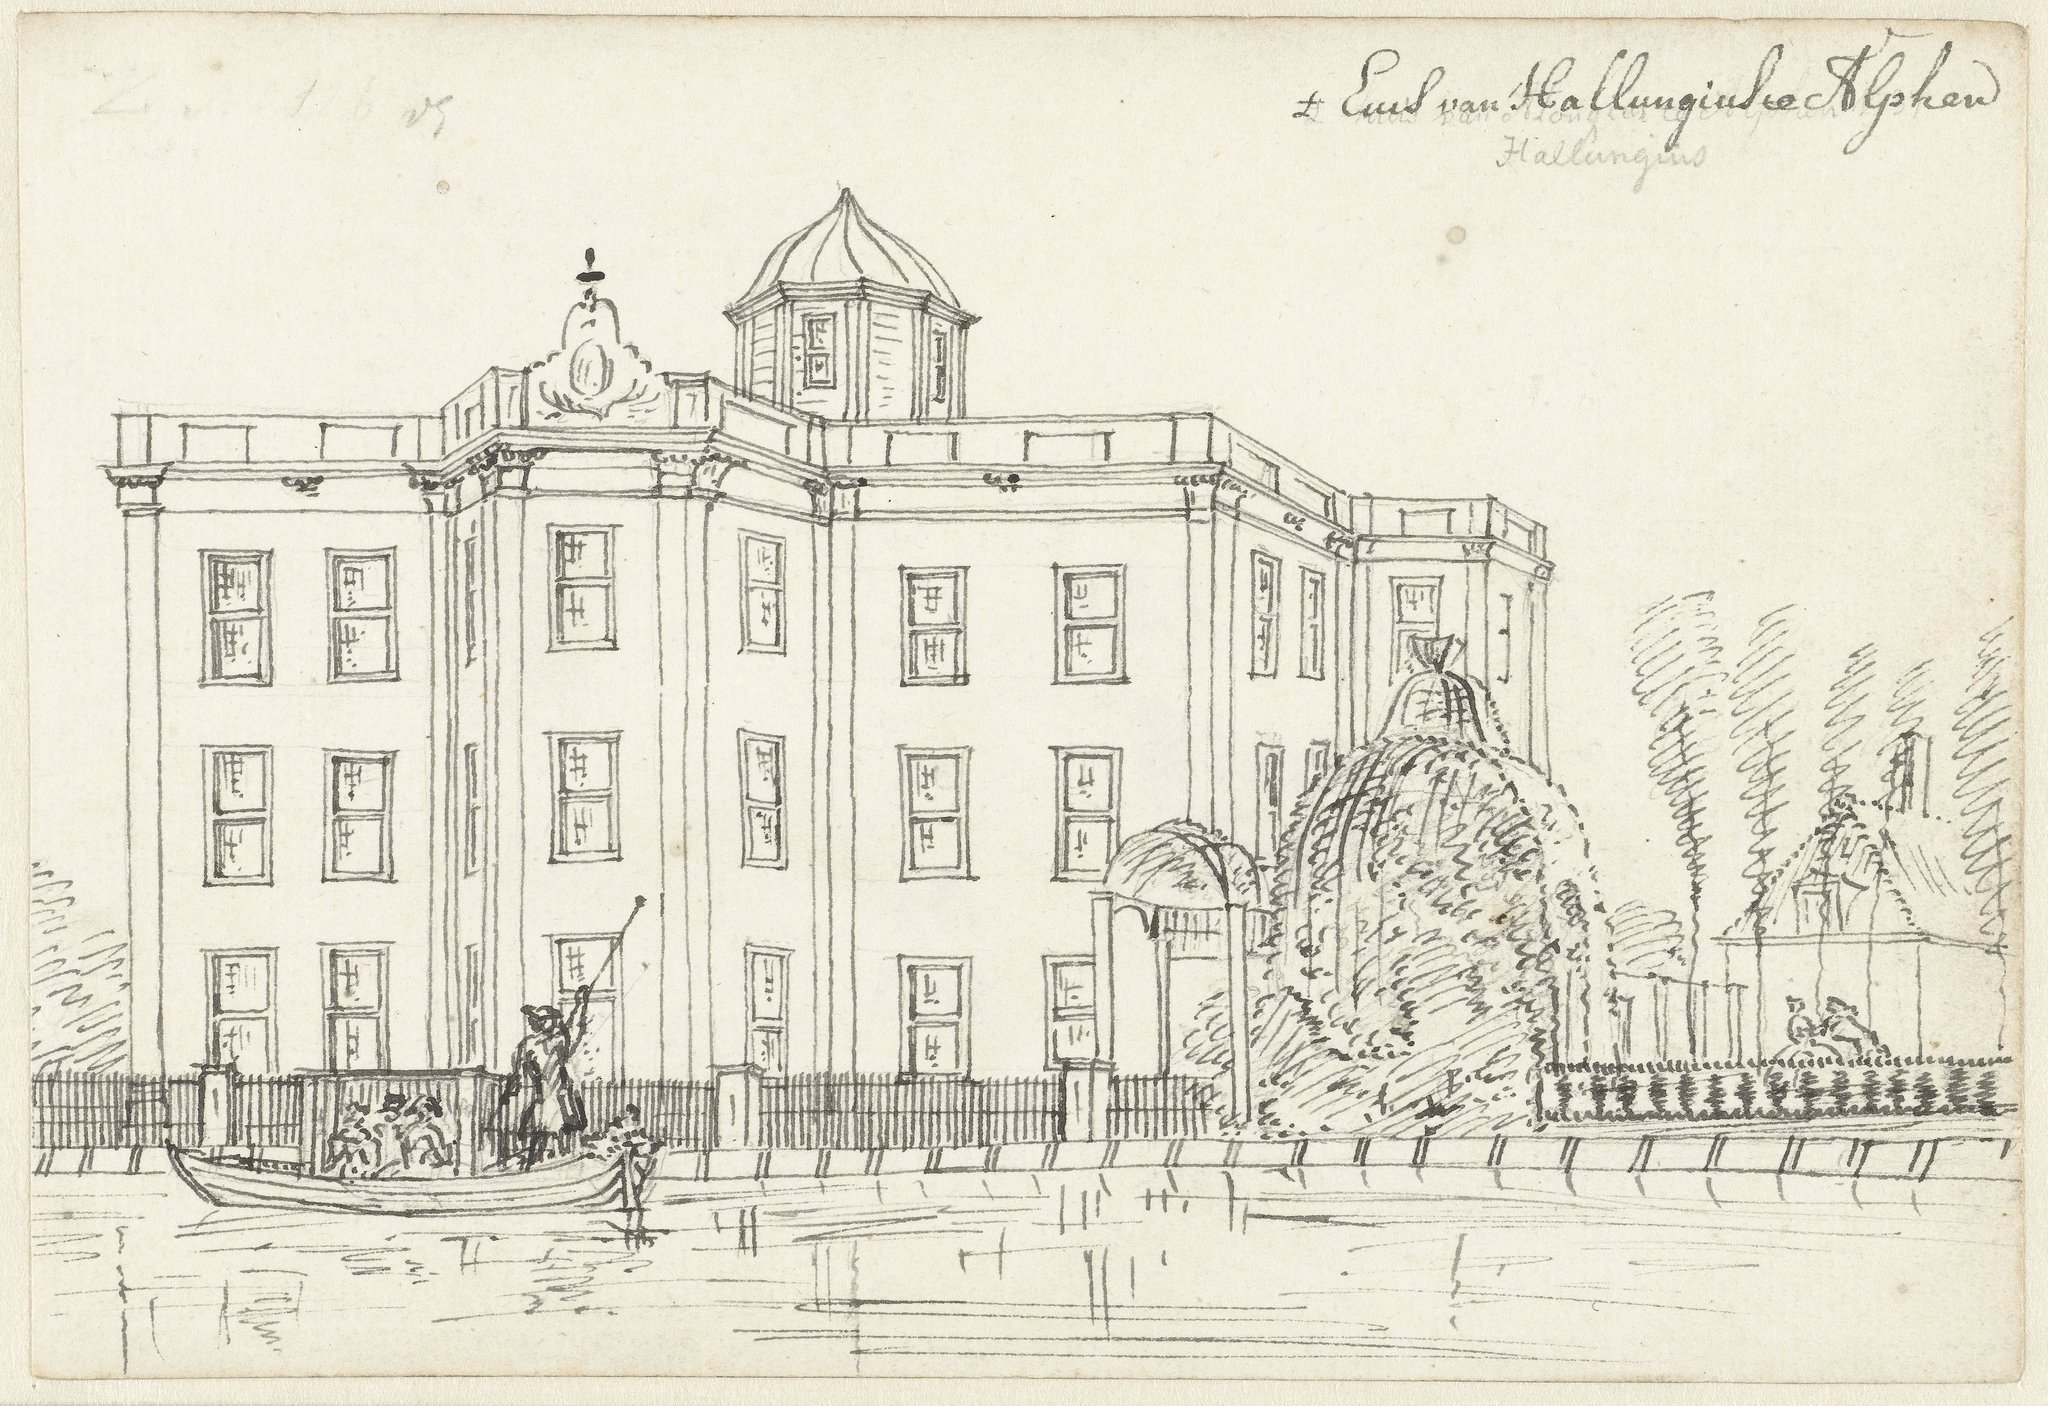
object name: drawing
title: Het huis van Allongius bij Alphen aan den Rijn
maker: cornelis pronk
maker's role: draughtsman, painter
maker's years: 1691-1759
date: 1701-1759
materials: ink, paper, pencil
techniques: pen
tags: city-view, and landscape with man-made constructions, rural housing, e.g. country-house, villa, cottage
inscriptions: inscription: ‘t Huis van Hallungius te Alphen’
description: Dit was het huis van de heer Allongius tot Alphen.